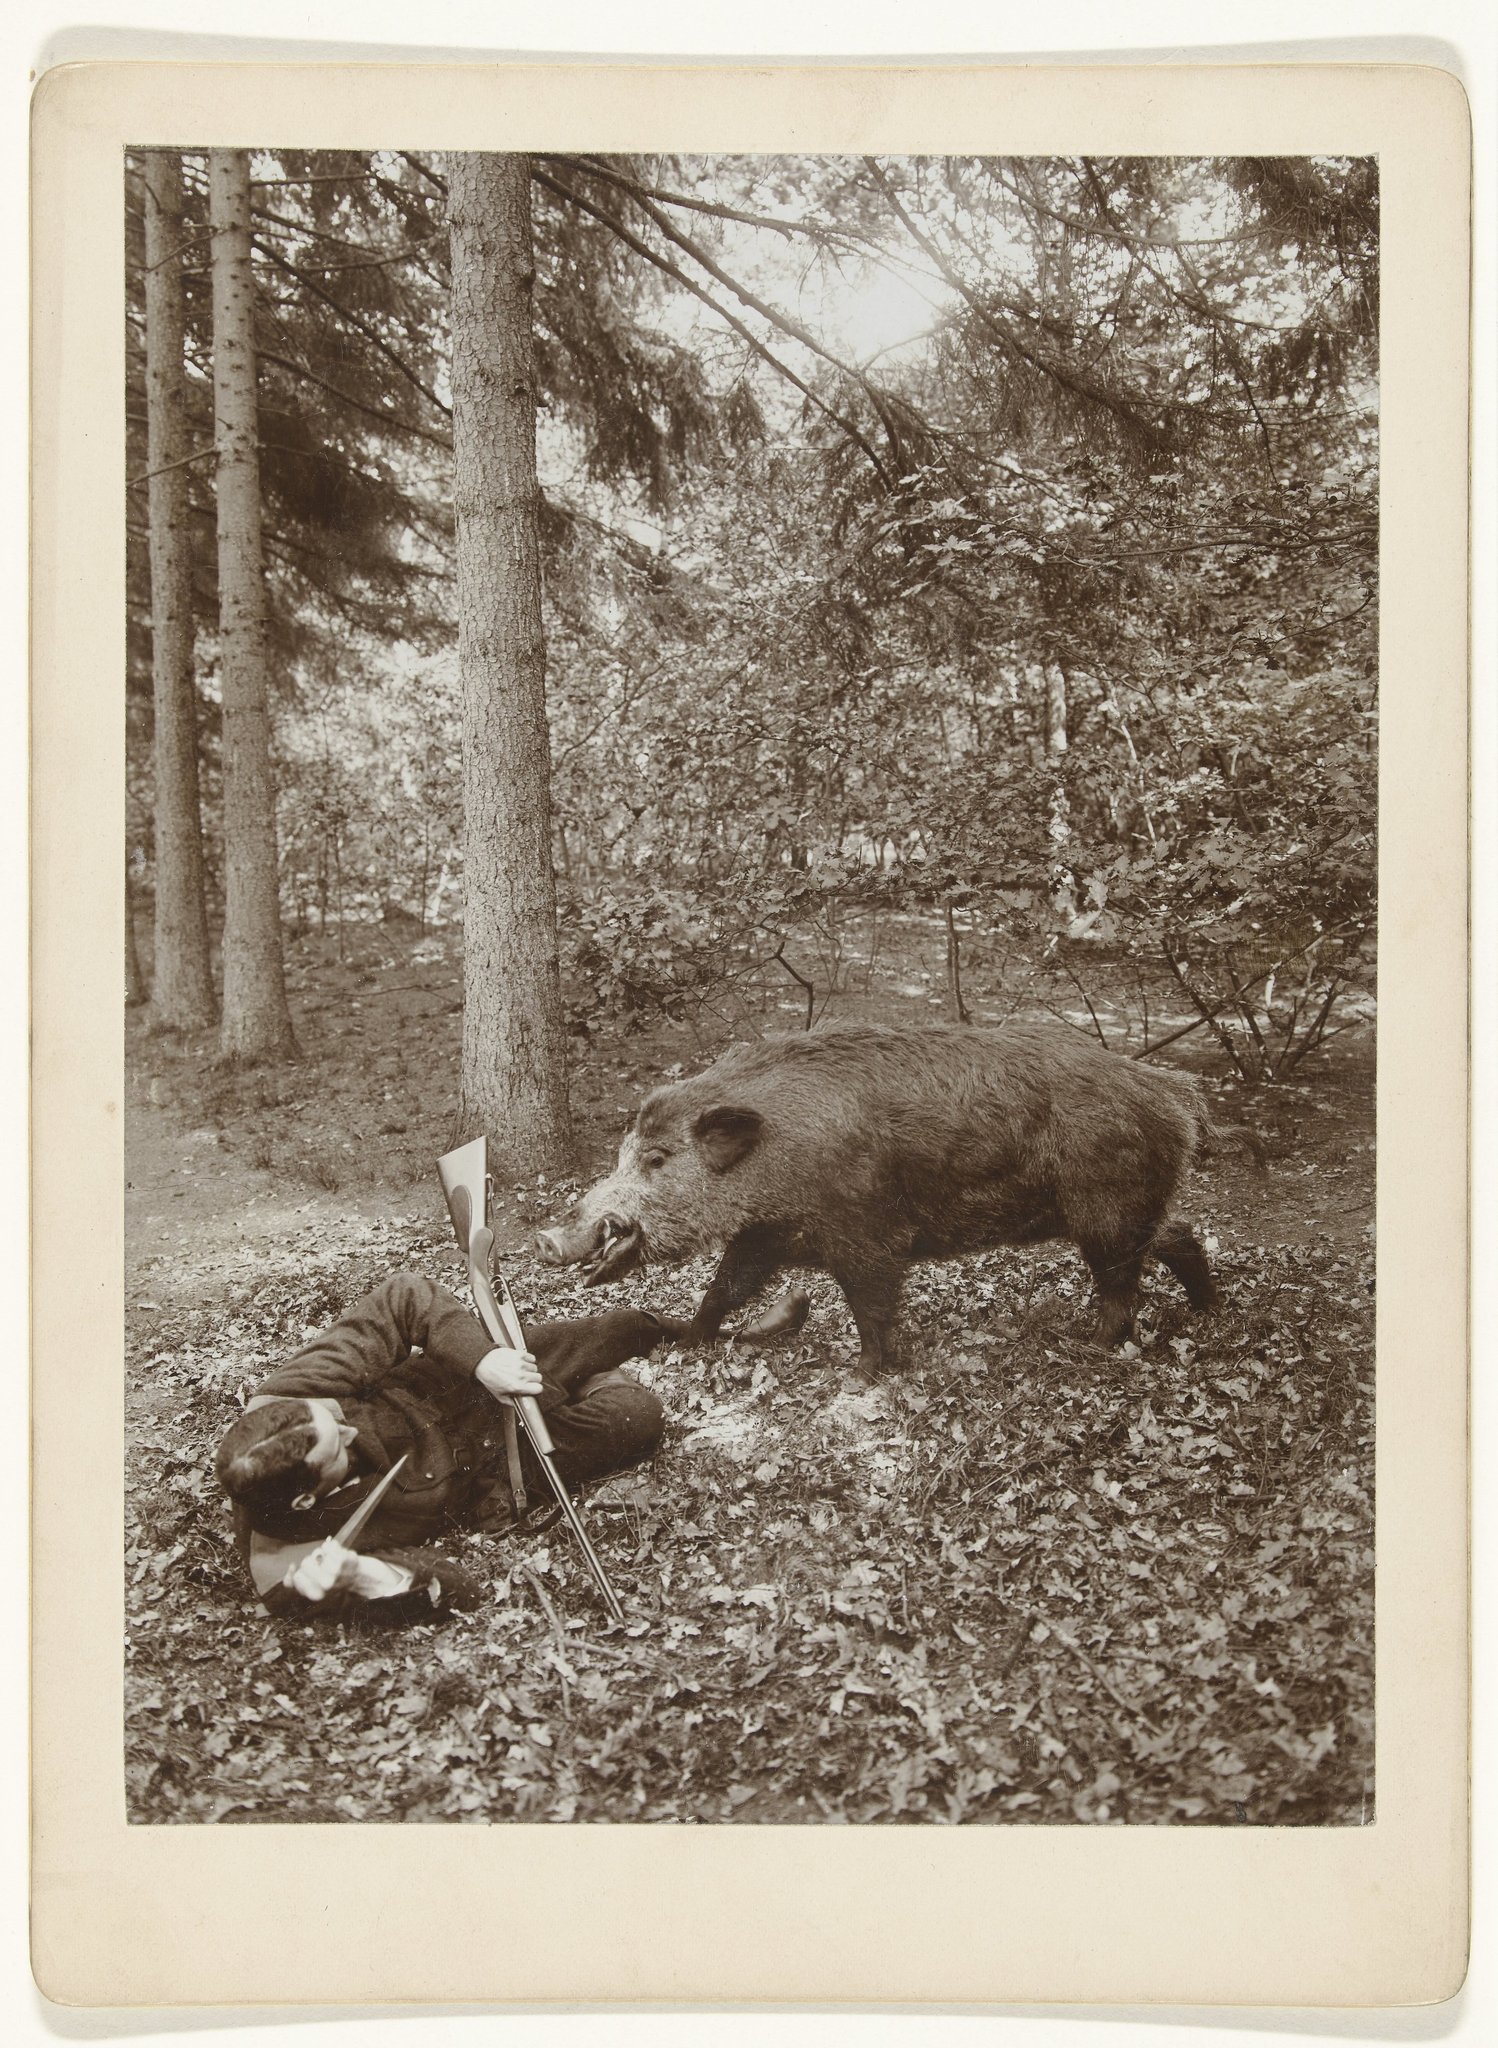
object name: photograph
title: Family Life at Pavia House in Zeist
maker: henry pauw van wieldrecht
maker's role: fotograaf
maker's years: 1863-1912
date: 1805-1898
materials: cardboard, photographic support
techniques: collodion silver print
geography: netherlands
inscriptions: annotation: ‘No 1497.’, signature: ‘H. Pauw v. Wieldrecht. / Mei 1898.’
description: These photographs reveal Pauw van Wieldrecht’s development from amateur to exceptionally talented photographer. His key subjects were family and domestic life in and around the family homes, travels, outings, and hunting. We see the photographer’s nephew Reinier (1897), brother Maarten defending himself from a charging (stuffed) wild boar (May 1898) and the domestic staff (August 1897).